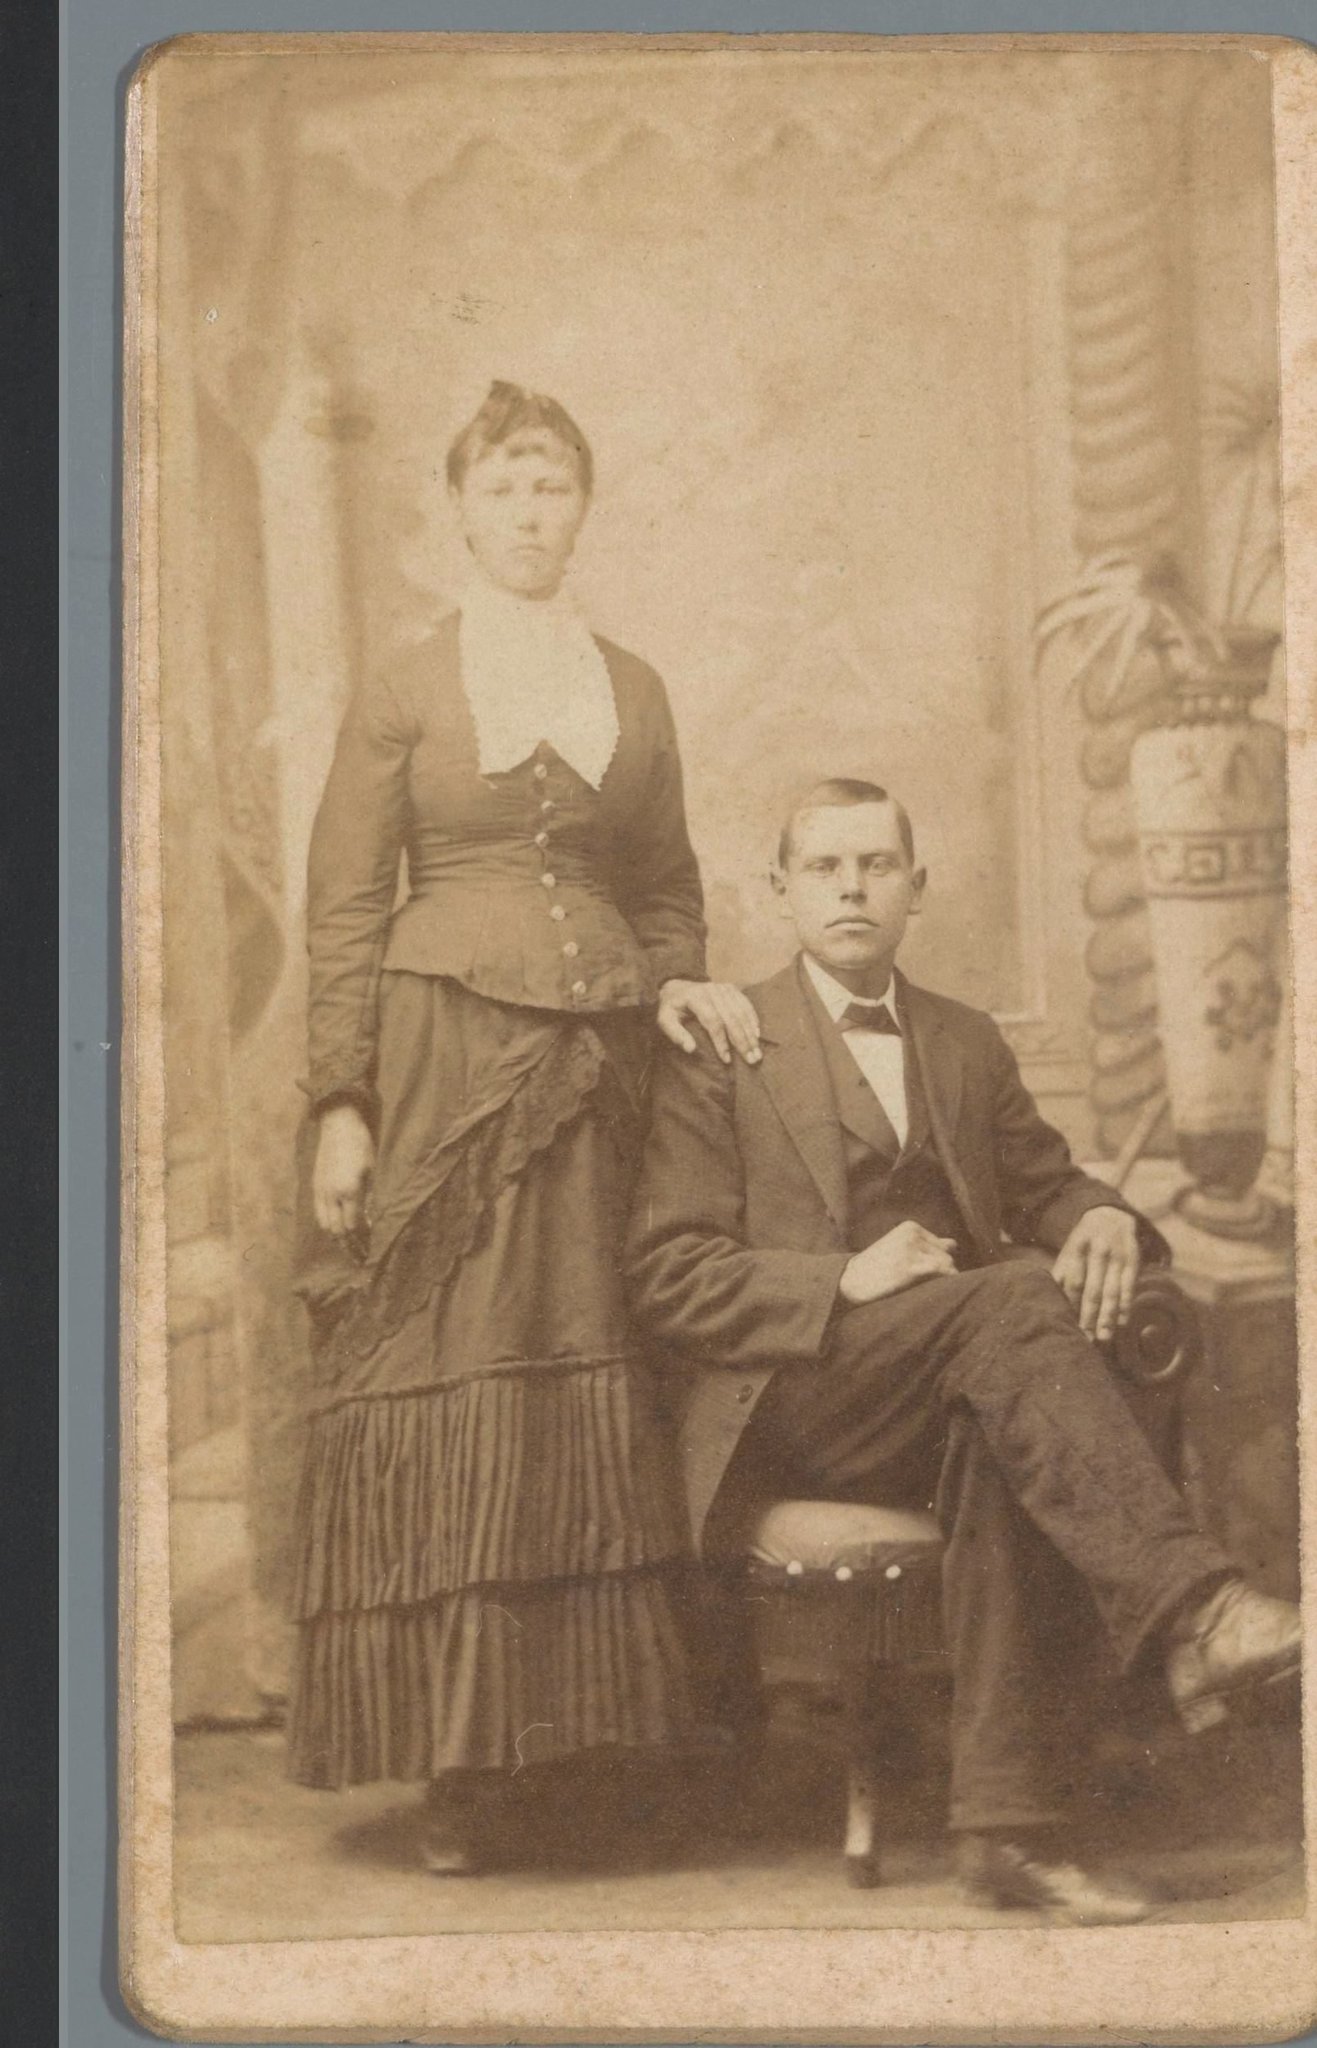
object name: carte de visite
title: Portret van een onbekende man en vrouw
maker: azariah m. burgess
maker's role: fotograaf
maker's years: -1894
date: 1876-1893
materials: cardboard, paper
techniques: albumen print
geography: netherlands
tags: adult woman, adult man, historical persons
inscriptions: inscription: ‘A. M. BURGESS,/ Photo. Artist/ Holland City,/ Mich.’